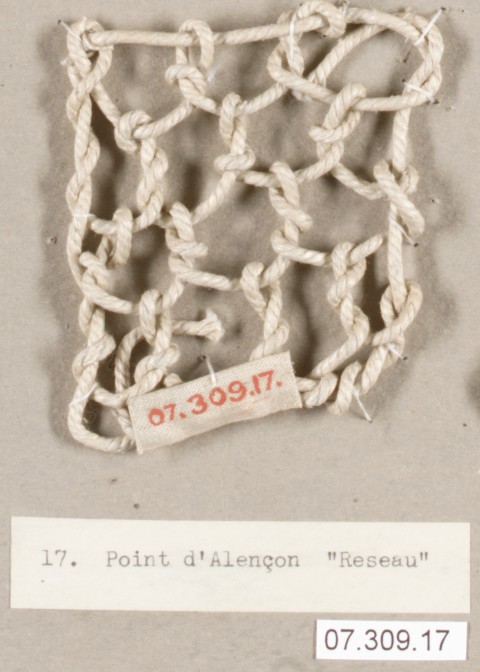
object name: stitch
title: Example of lace stitch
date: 1801-2000